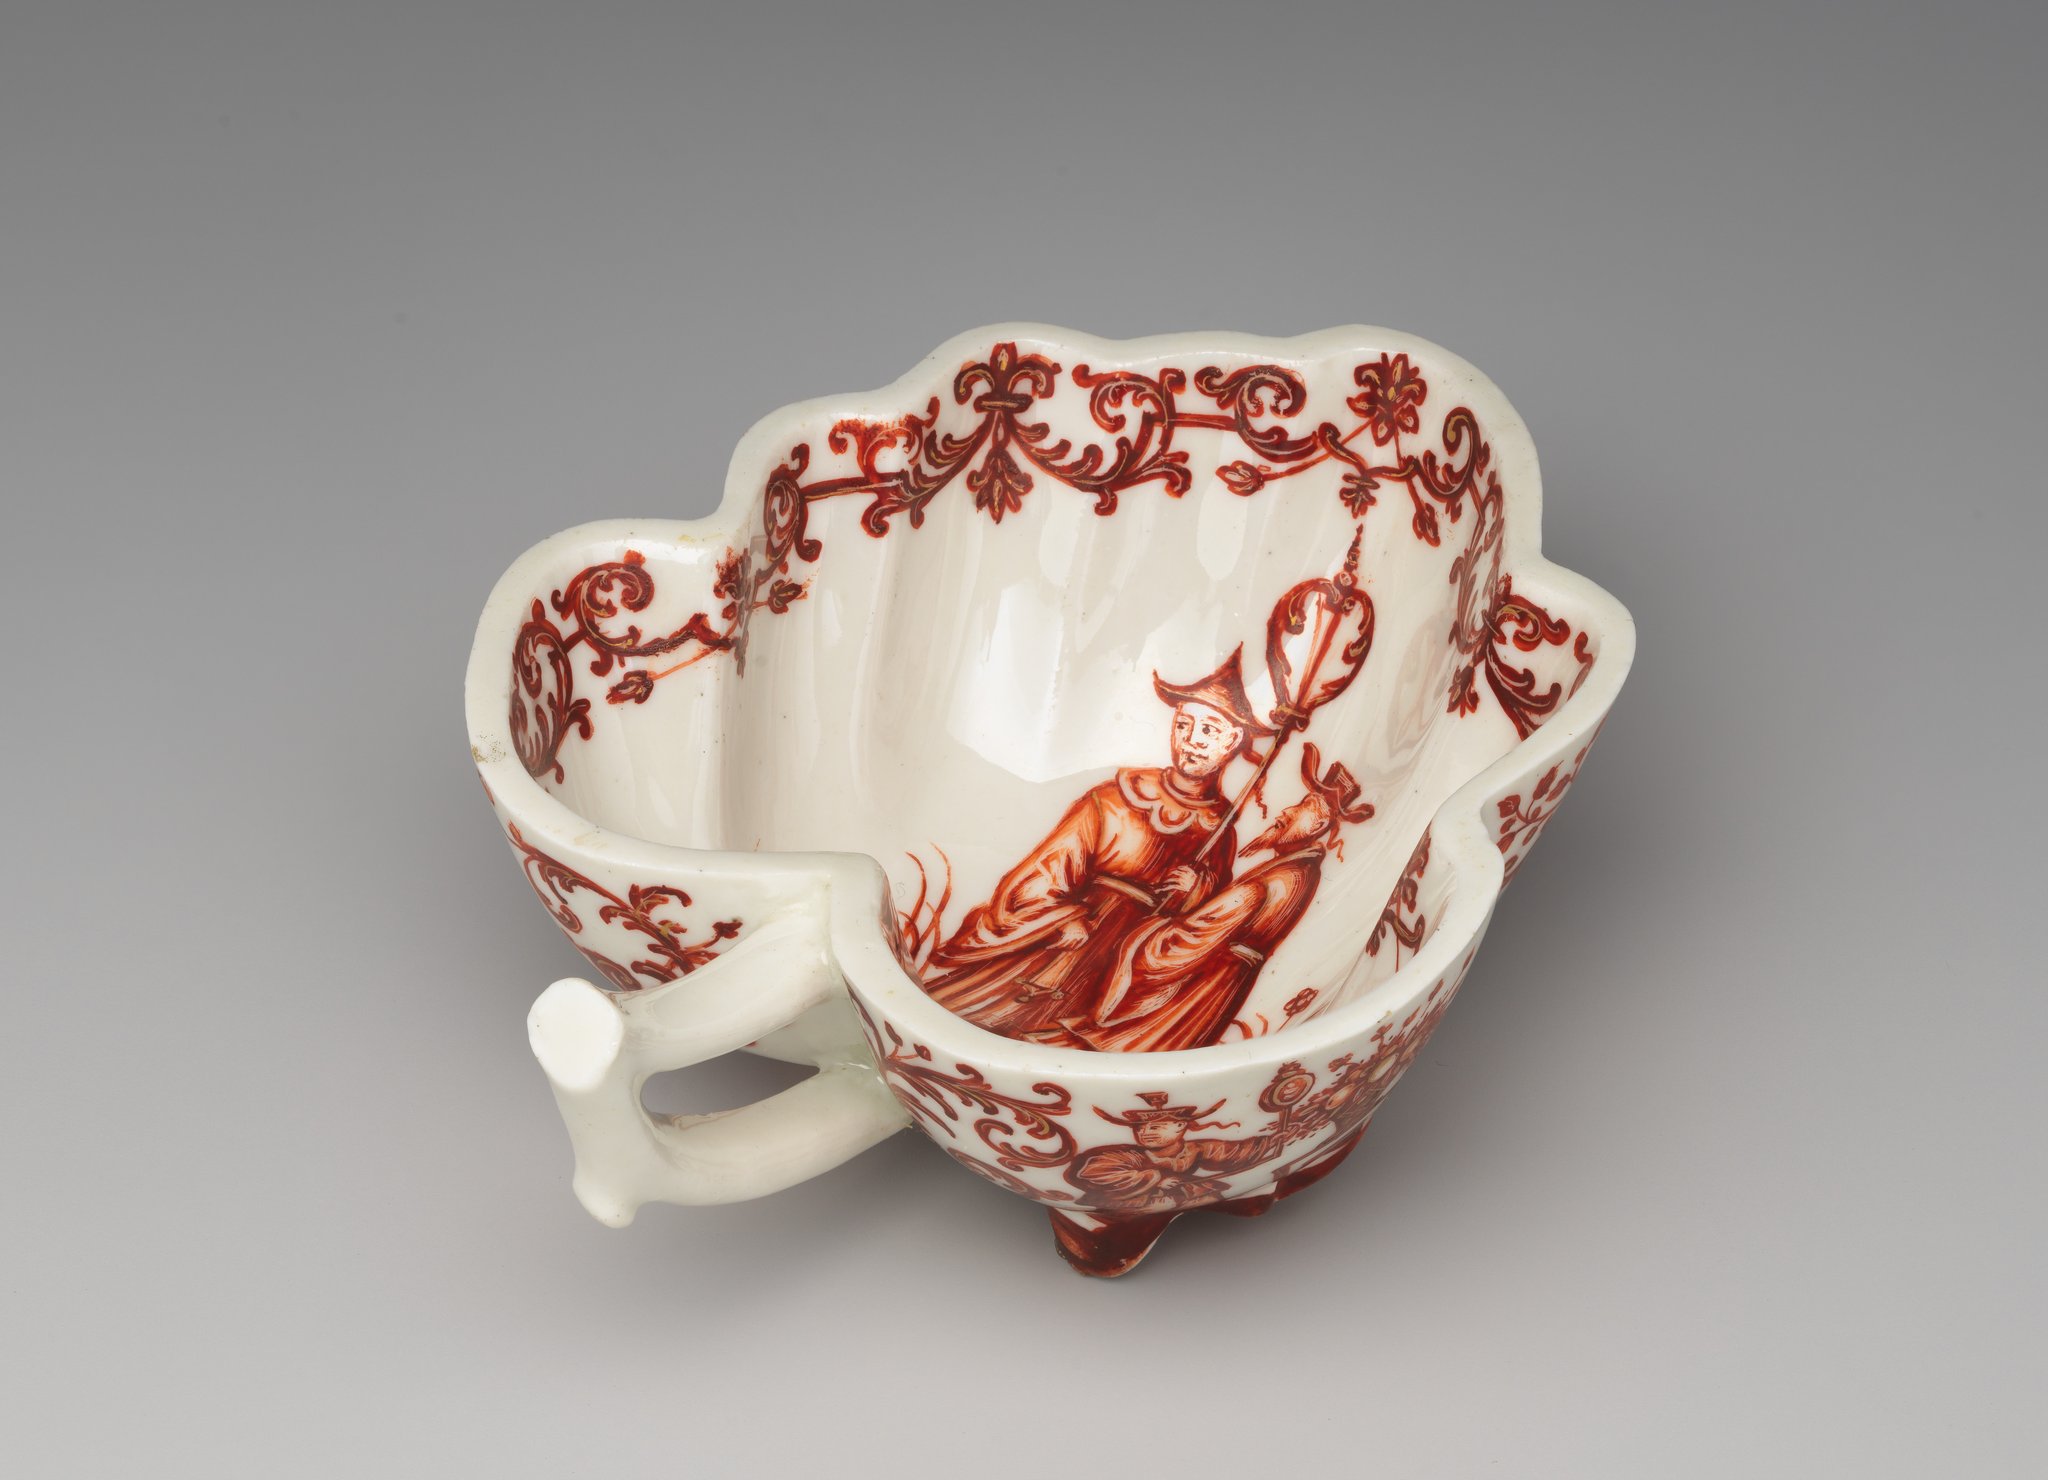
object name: dish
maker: meissen manufactory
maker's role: manufactory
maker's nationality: german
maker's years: 1710-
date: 1725-1732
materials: hard paste porcelain